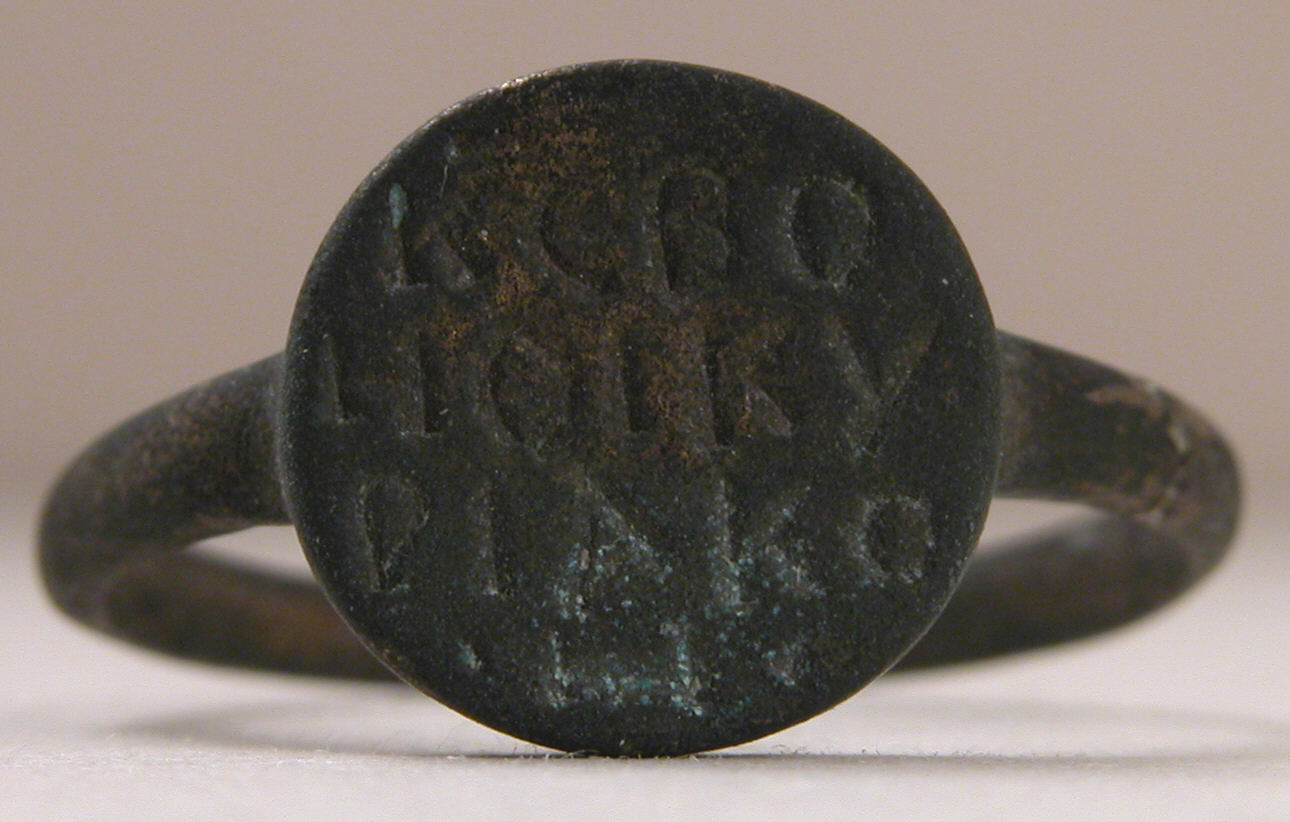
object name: ring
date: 401-800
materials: bronze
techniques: engraving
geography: palestine